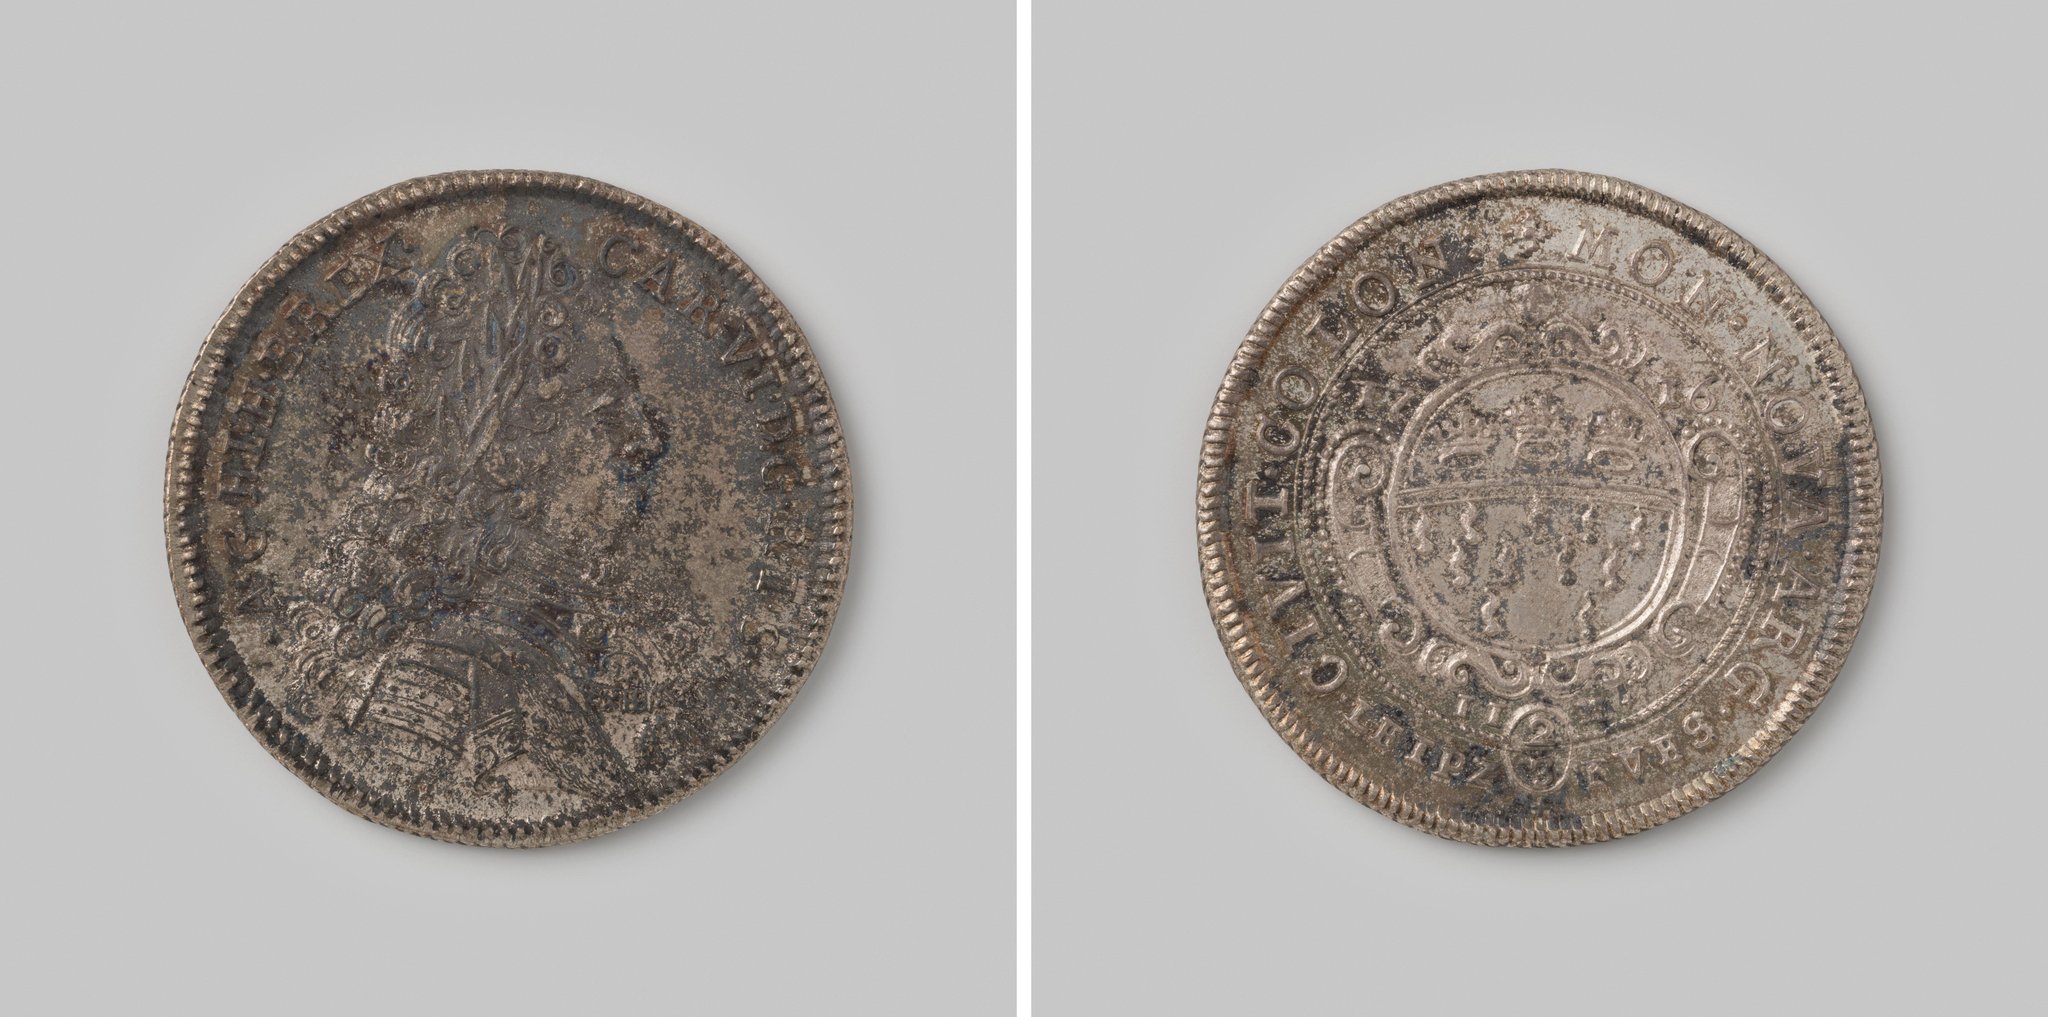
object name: coin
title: Tweederde taler van de rijksstad Keulen, 1716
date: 1716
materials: silver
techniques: striking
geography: cologne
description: Zilveren munt. Voorzijde: portret van keizer Karel VI naar rechts. Keerzijde: tussen jaartal versierd ovaal wapenschild van de stad, waaronder waarde-aanduiding. Kabelrand.